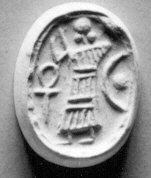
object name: stamp seal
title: Stamp seal (scaraboid) with cultic scene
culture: syro-levantine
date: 750-701 BCE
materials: stone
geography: levant or mesopotamia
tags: ankh